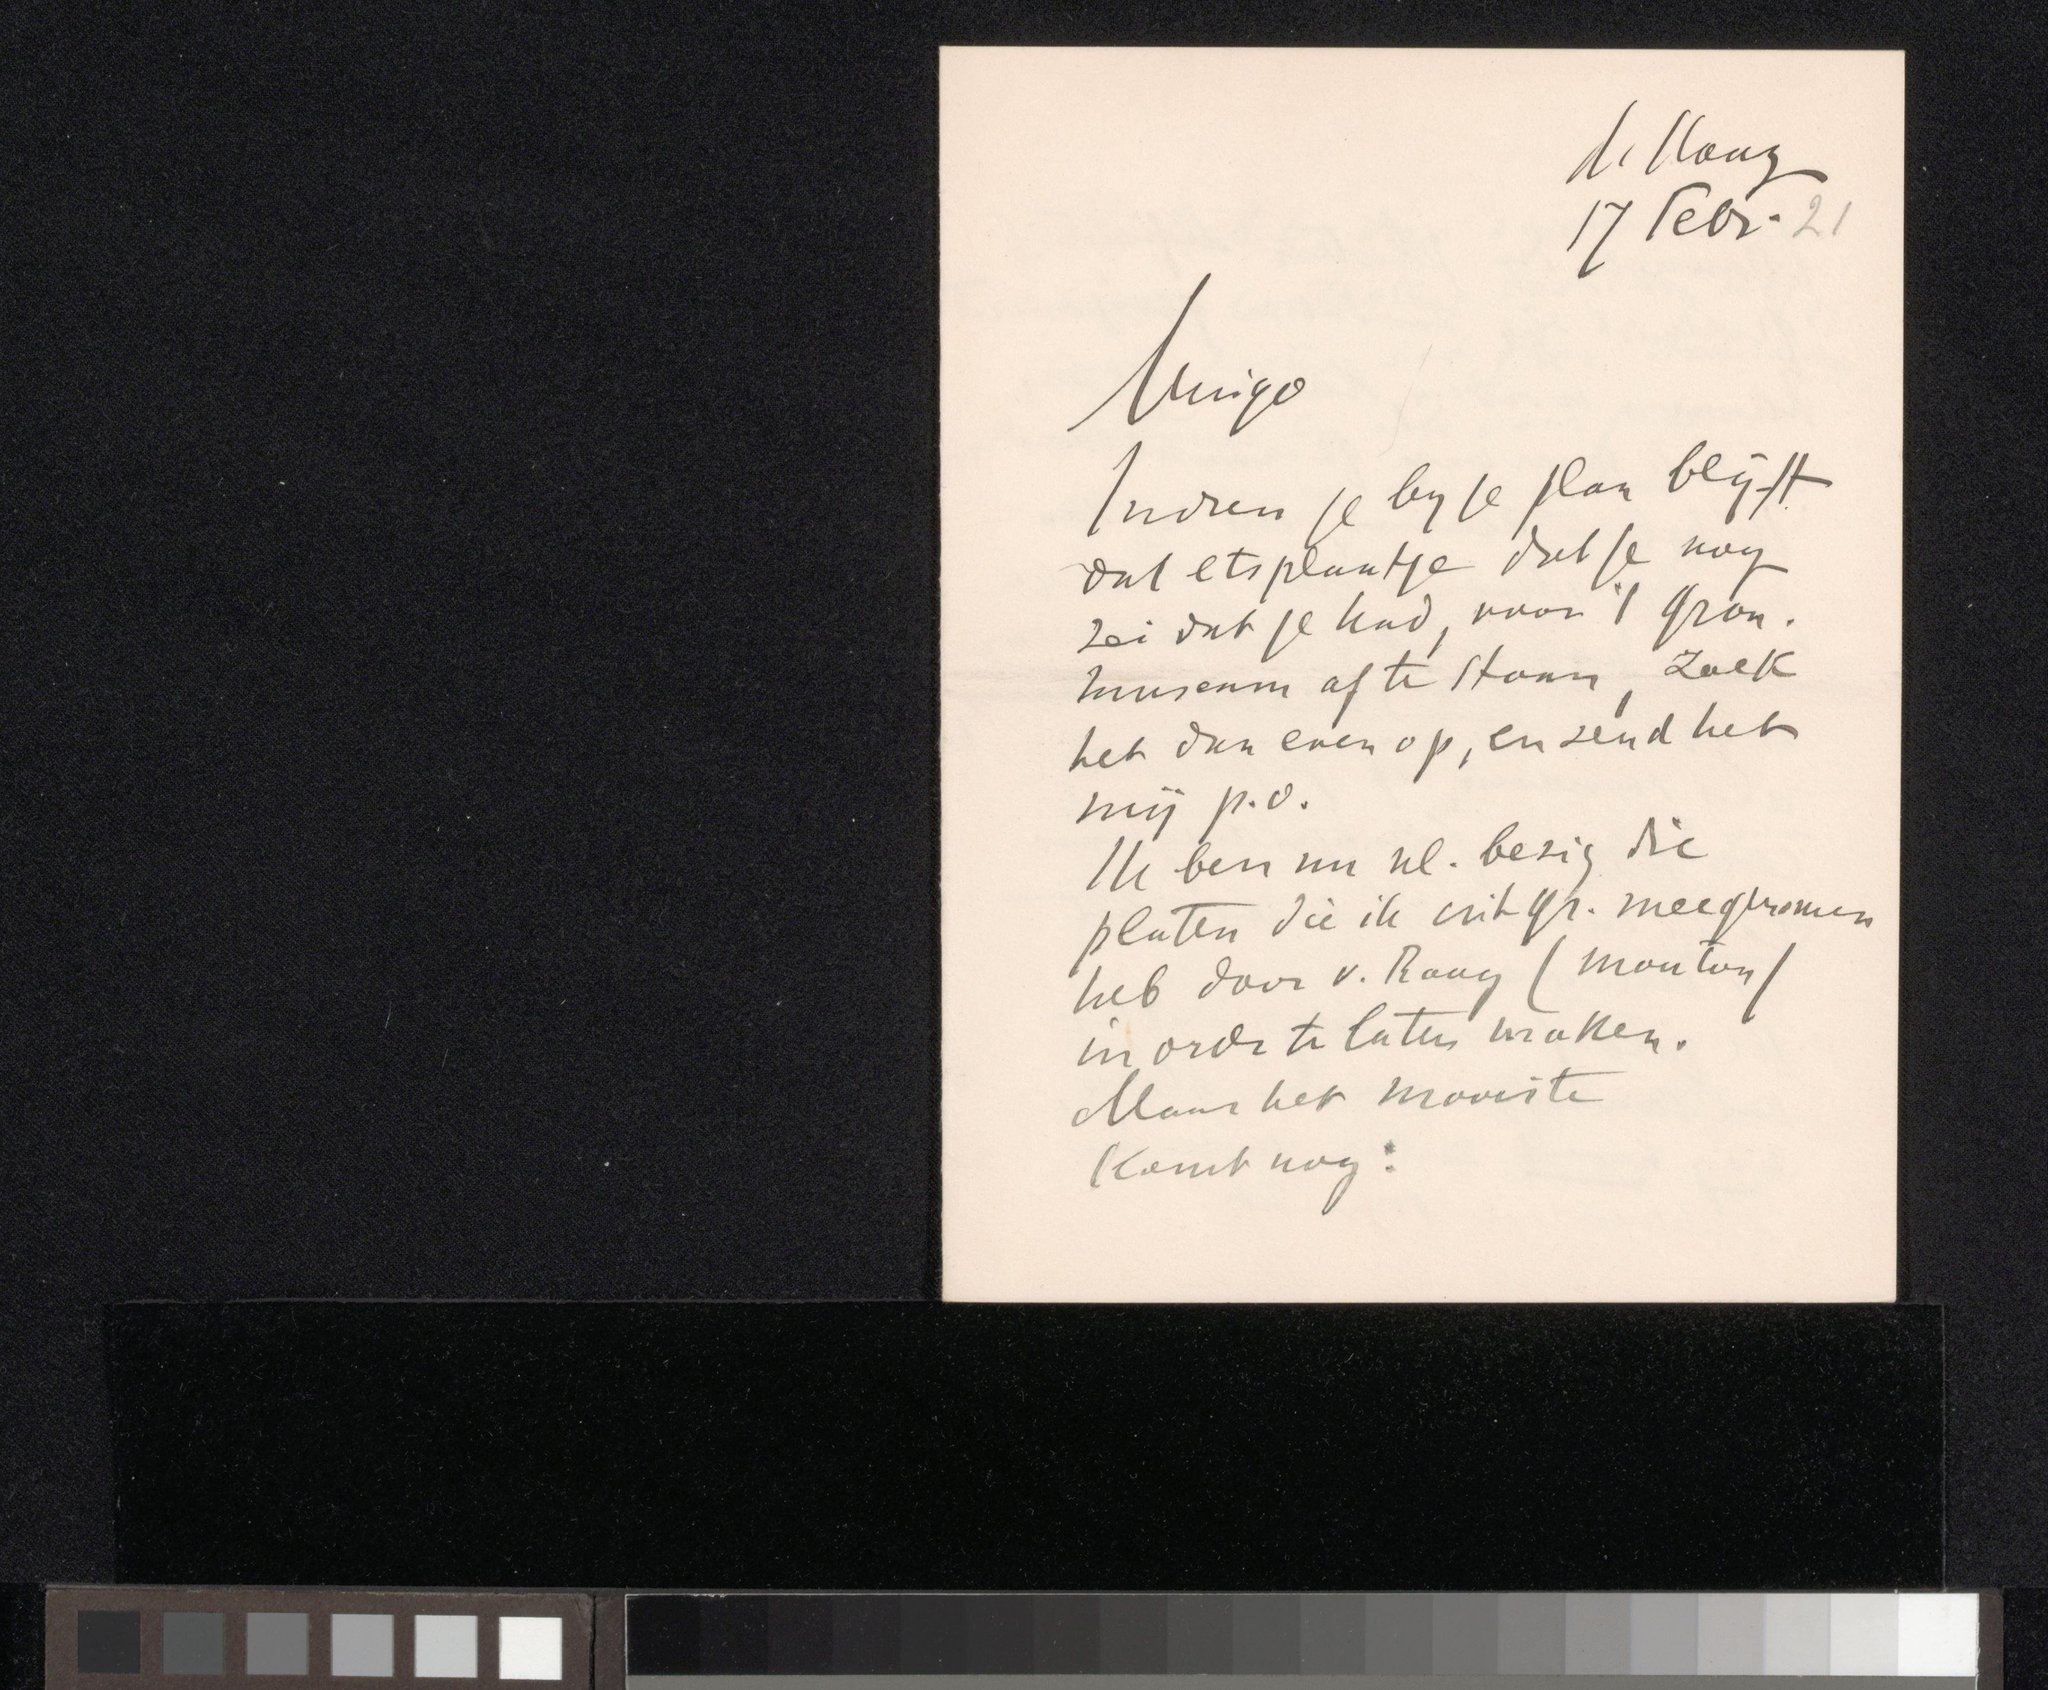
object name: letter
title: Brief aan Jan Veth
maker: isaac israels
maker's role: draughtsman, painter, print maker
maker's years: 1865-1934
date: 1875-1925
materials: ink, paper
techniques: pen, writing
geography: the hague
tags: painter, dordrecht, amsterdam, draughtsman, designer, jan veth, martinus mouton, the graphic arts, exhibition ~ art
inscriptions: collector's mark: ‘RPK’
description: Gedateerd 17 februari. In latere hand 21.